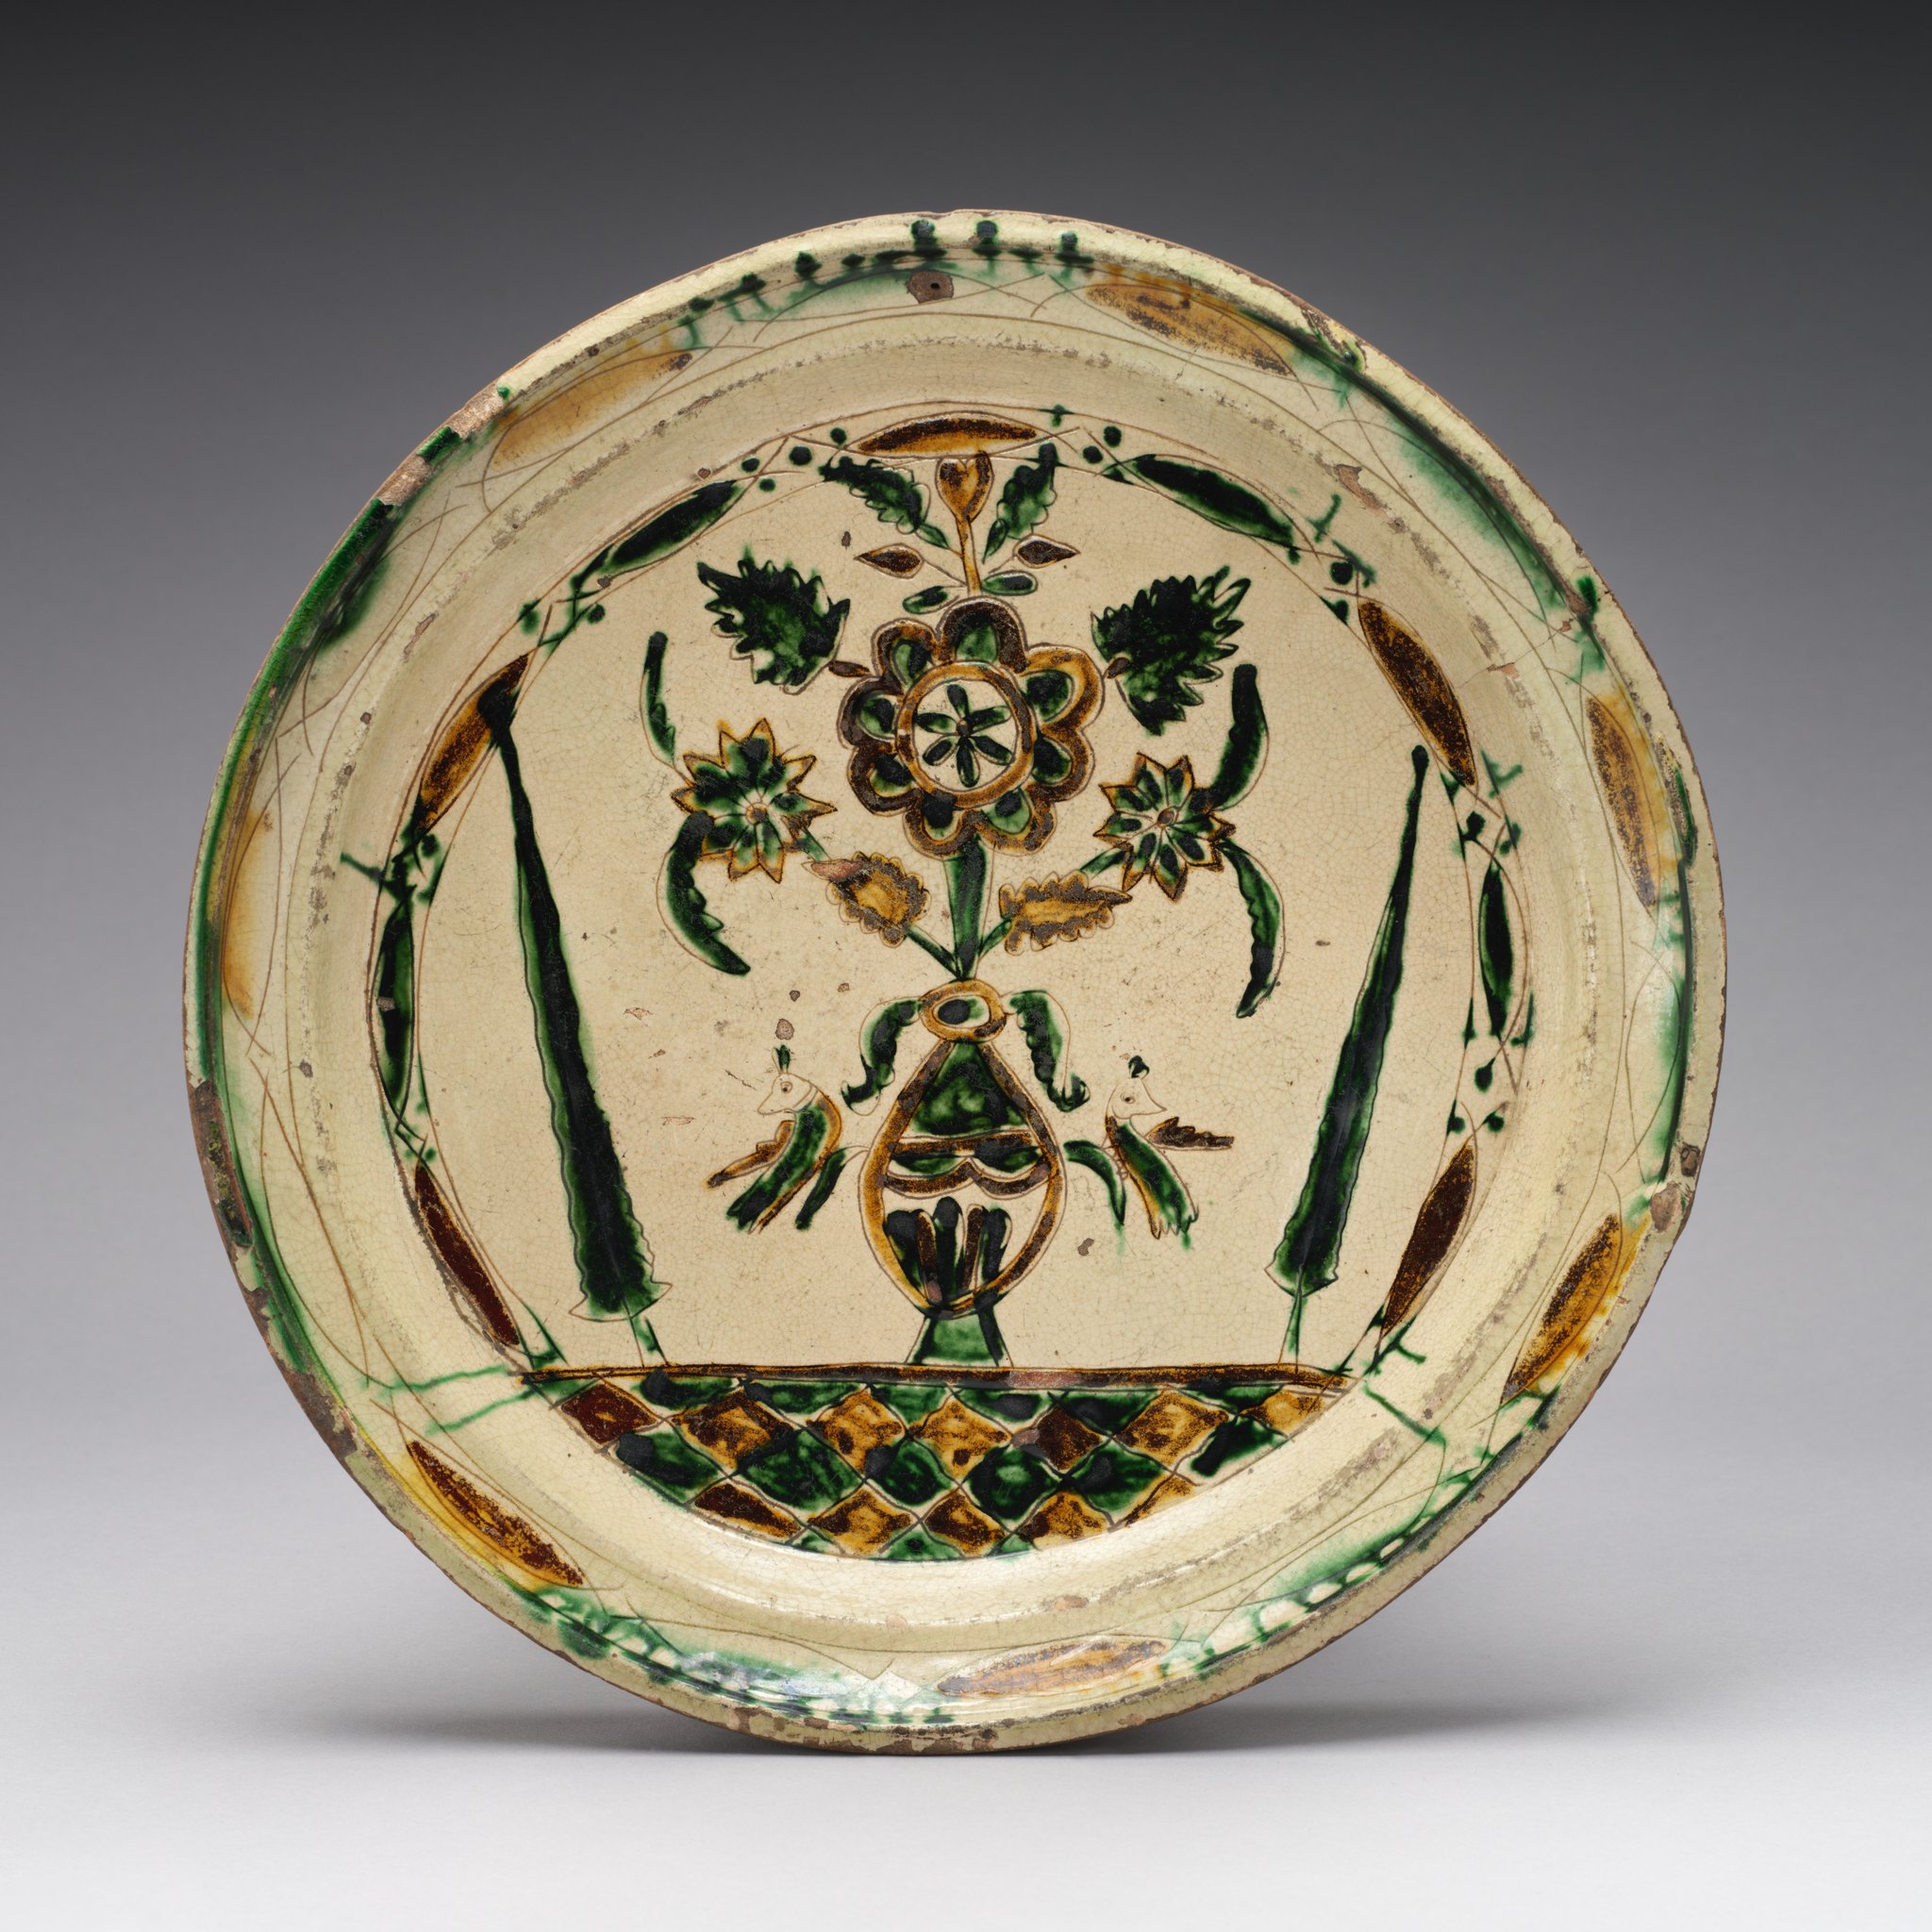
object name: plate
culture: mexican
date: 1830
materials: earthenware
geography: mexico